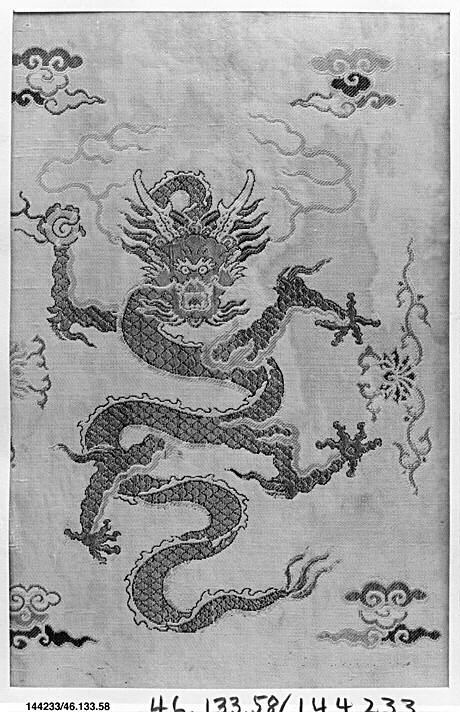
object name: piece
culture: chinese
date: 1501-1700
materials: metal thread, silk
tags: dragons